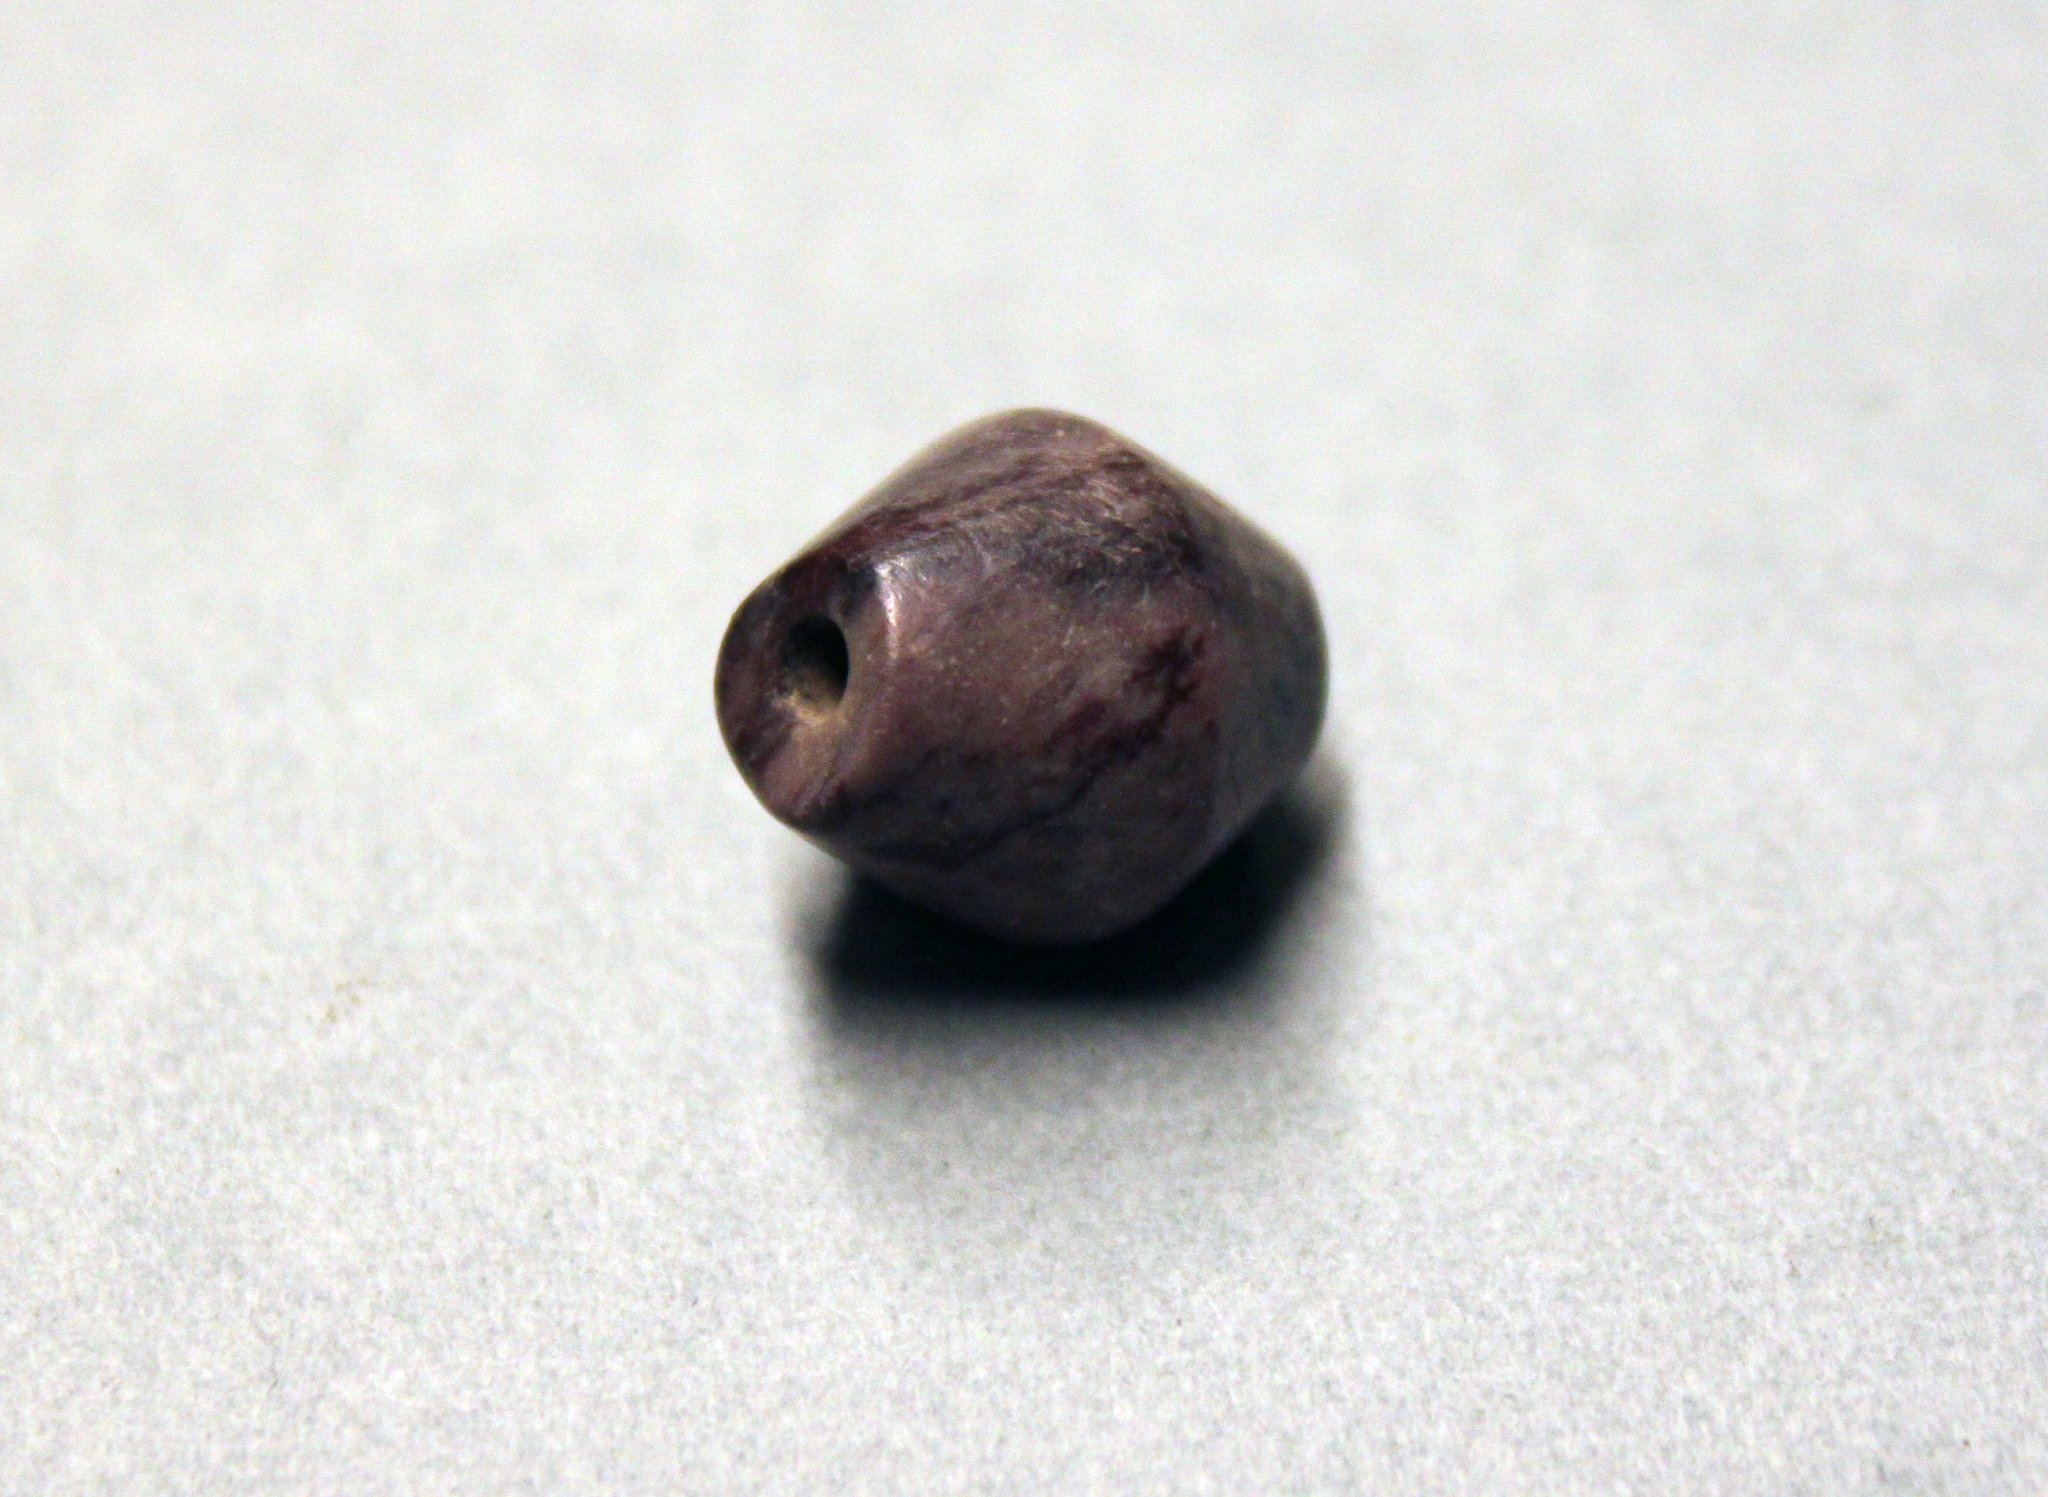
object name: bead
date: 701-1200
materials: stone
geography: iran